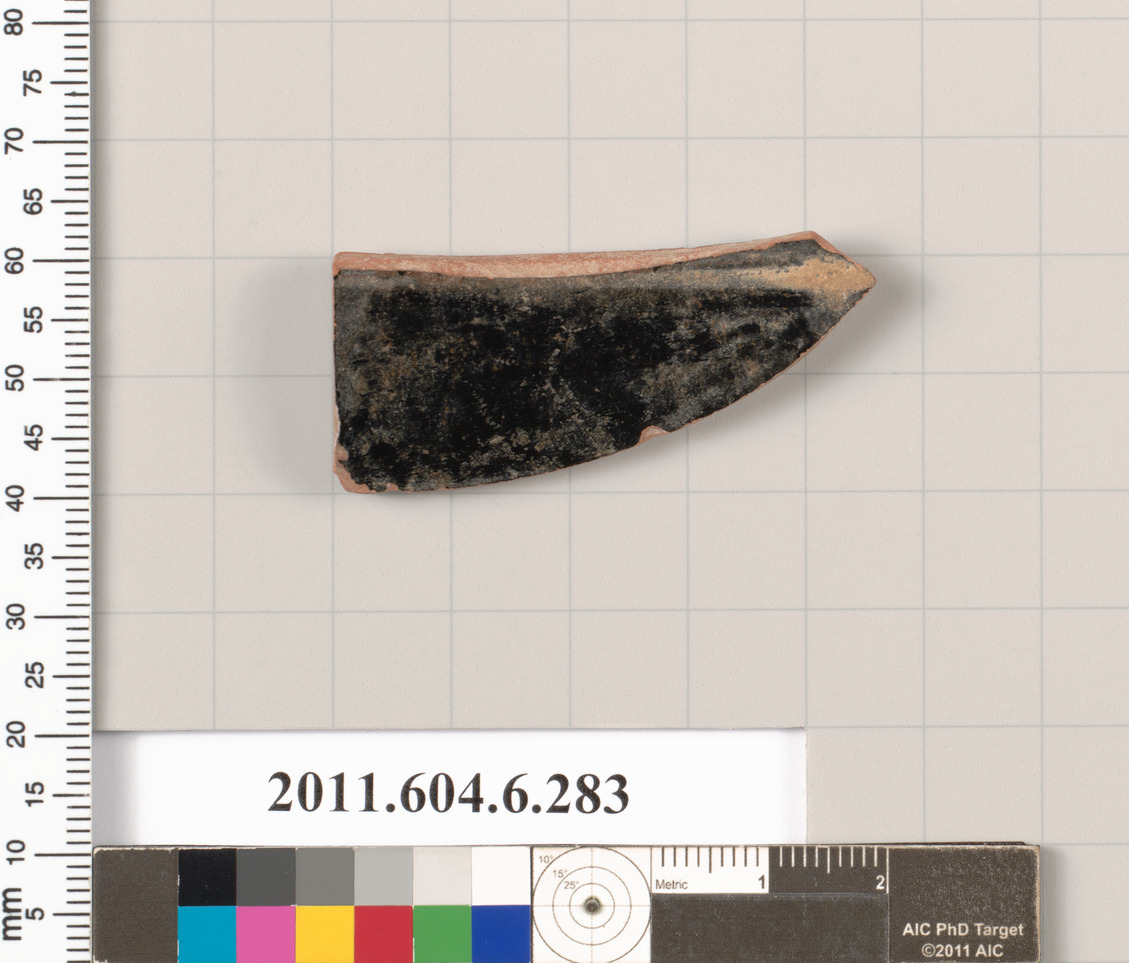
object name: undetermined open shape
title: Terracotta fragment of an open shape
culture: greek, attic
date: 600-301 BCE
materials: terracotta